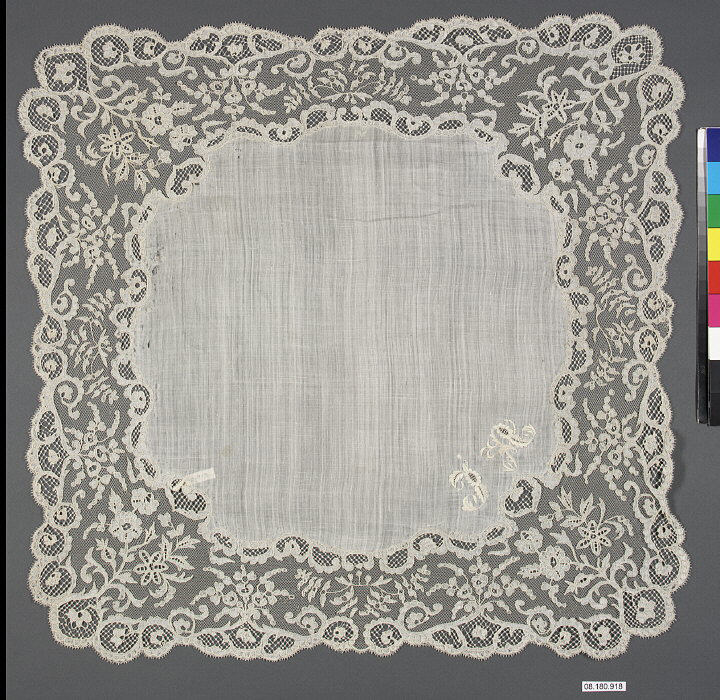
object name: handkerchief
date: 1801-1900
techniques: embroidery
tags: flowers